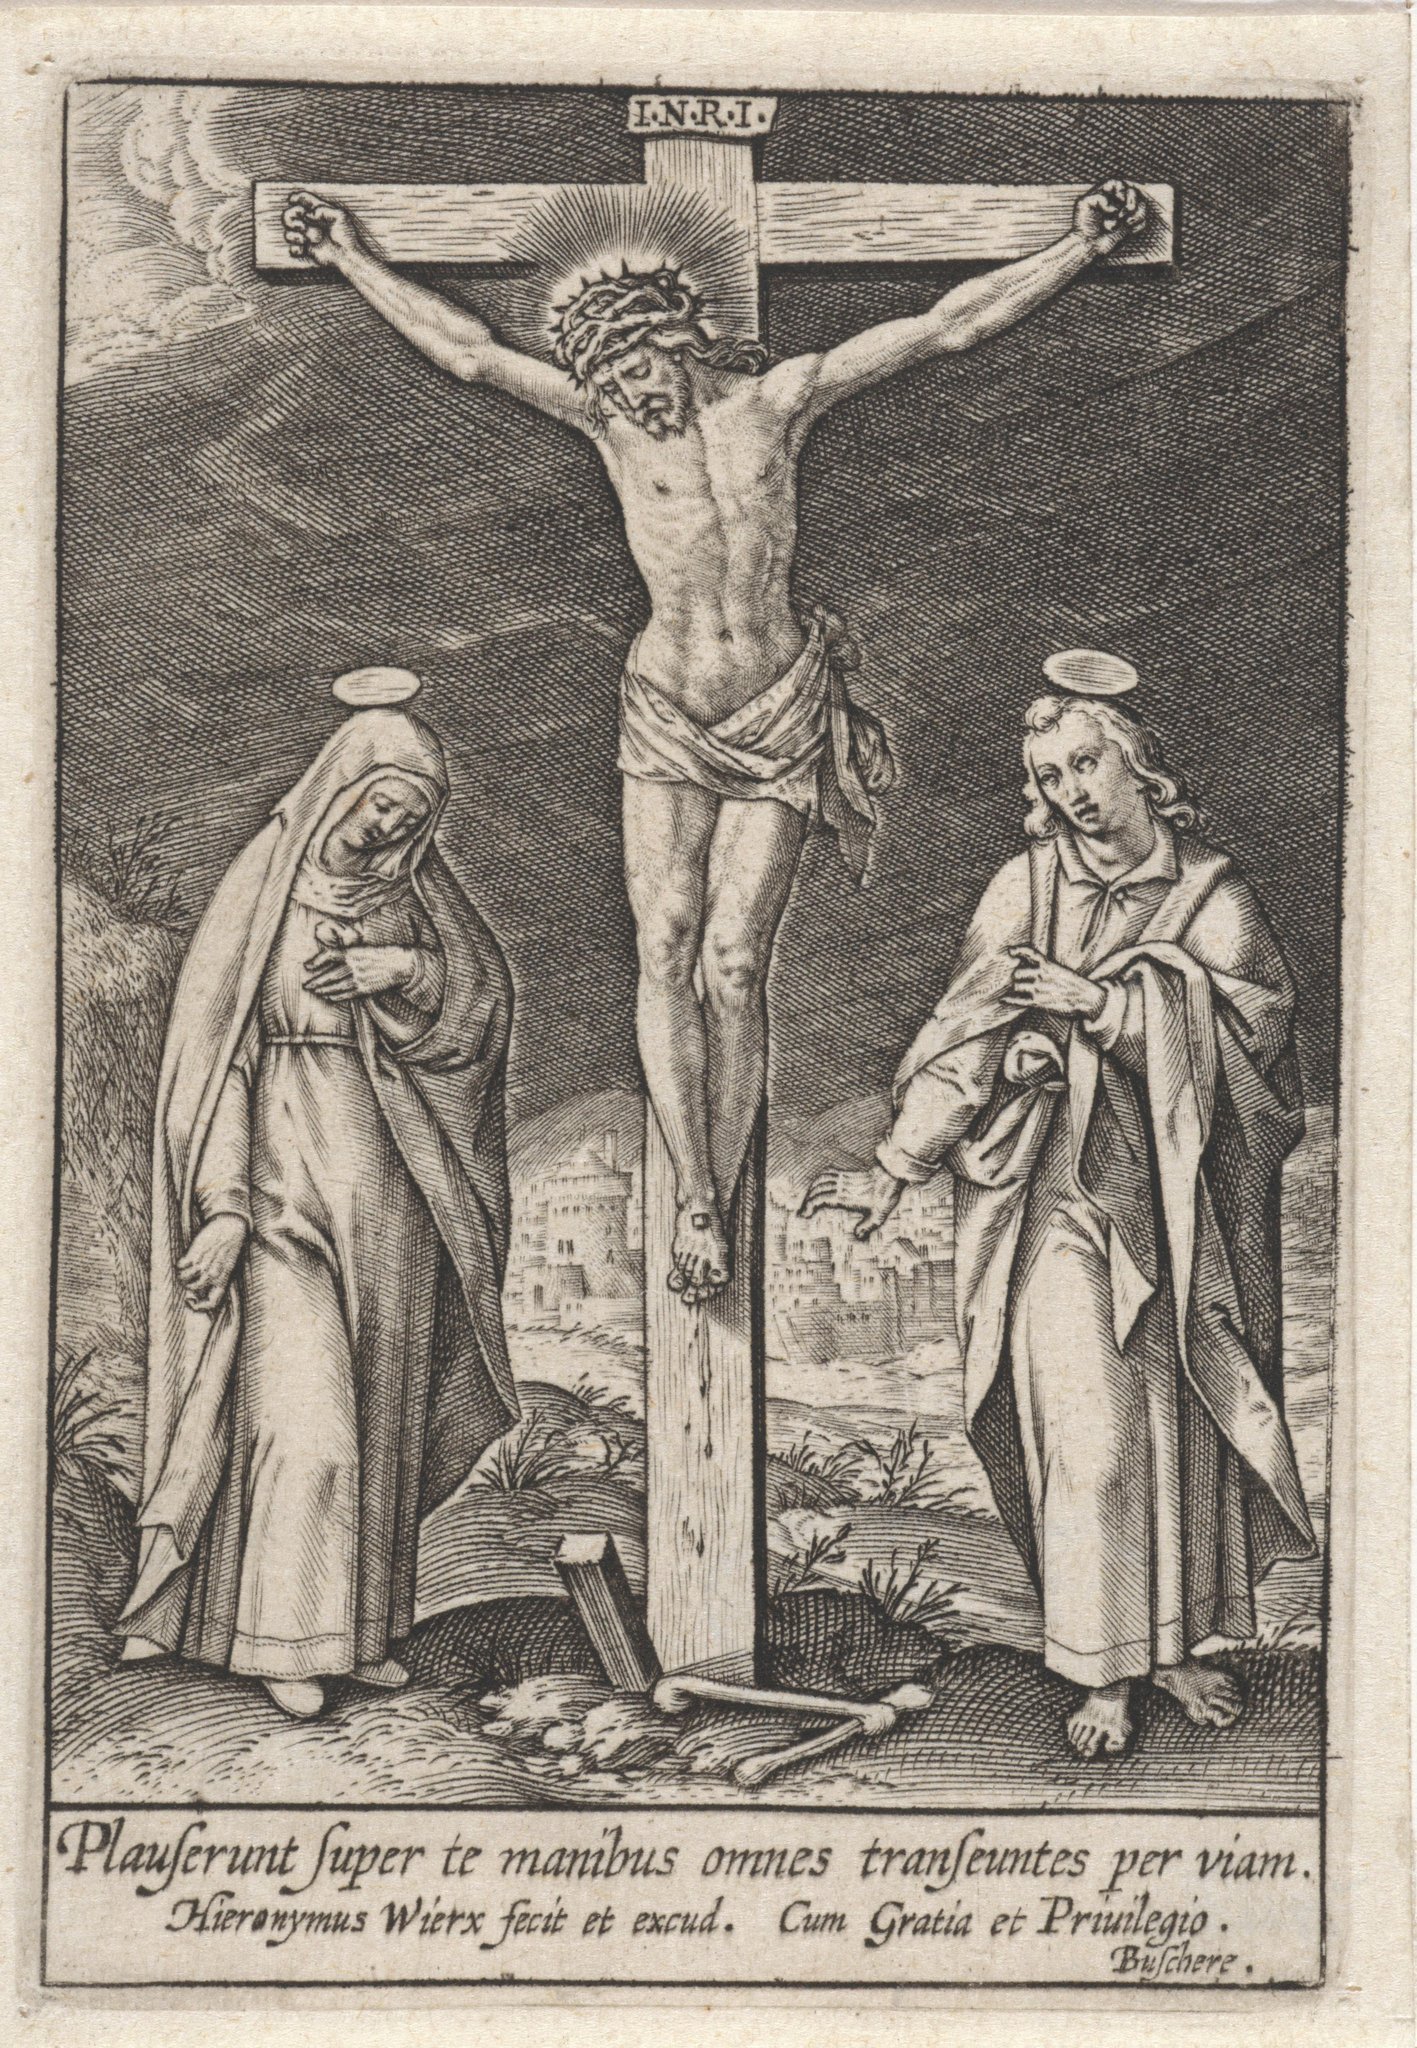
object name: print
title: Kruisiging van Christus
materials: paper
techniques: engraving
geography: antwerp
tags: crucified christ, with particular persons under the cross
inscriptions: collector's mark: Lugt 2228, collector's mark: Lugt 2542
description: Christus hangt aan het kruis. Aan de voet van het kruis Maria en Johannes. In de marge een onderschrift in het Latijn.